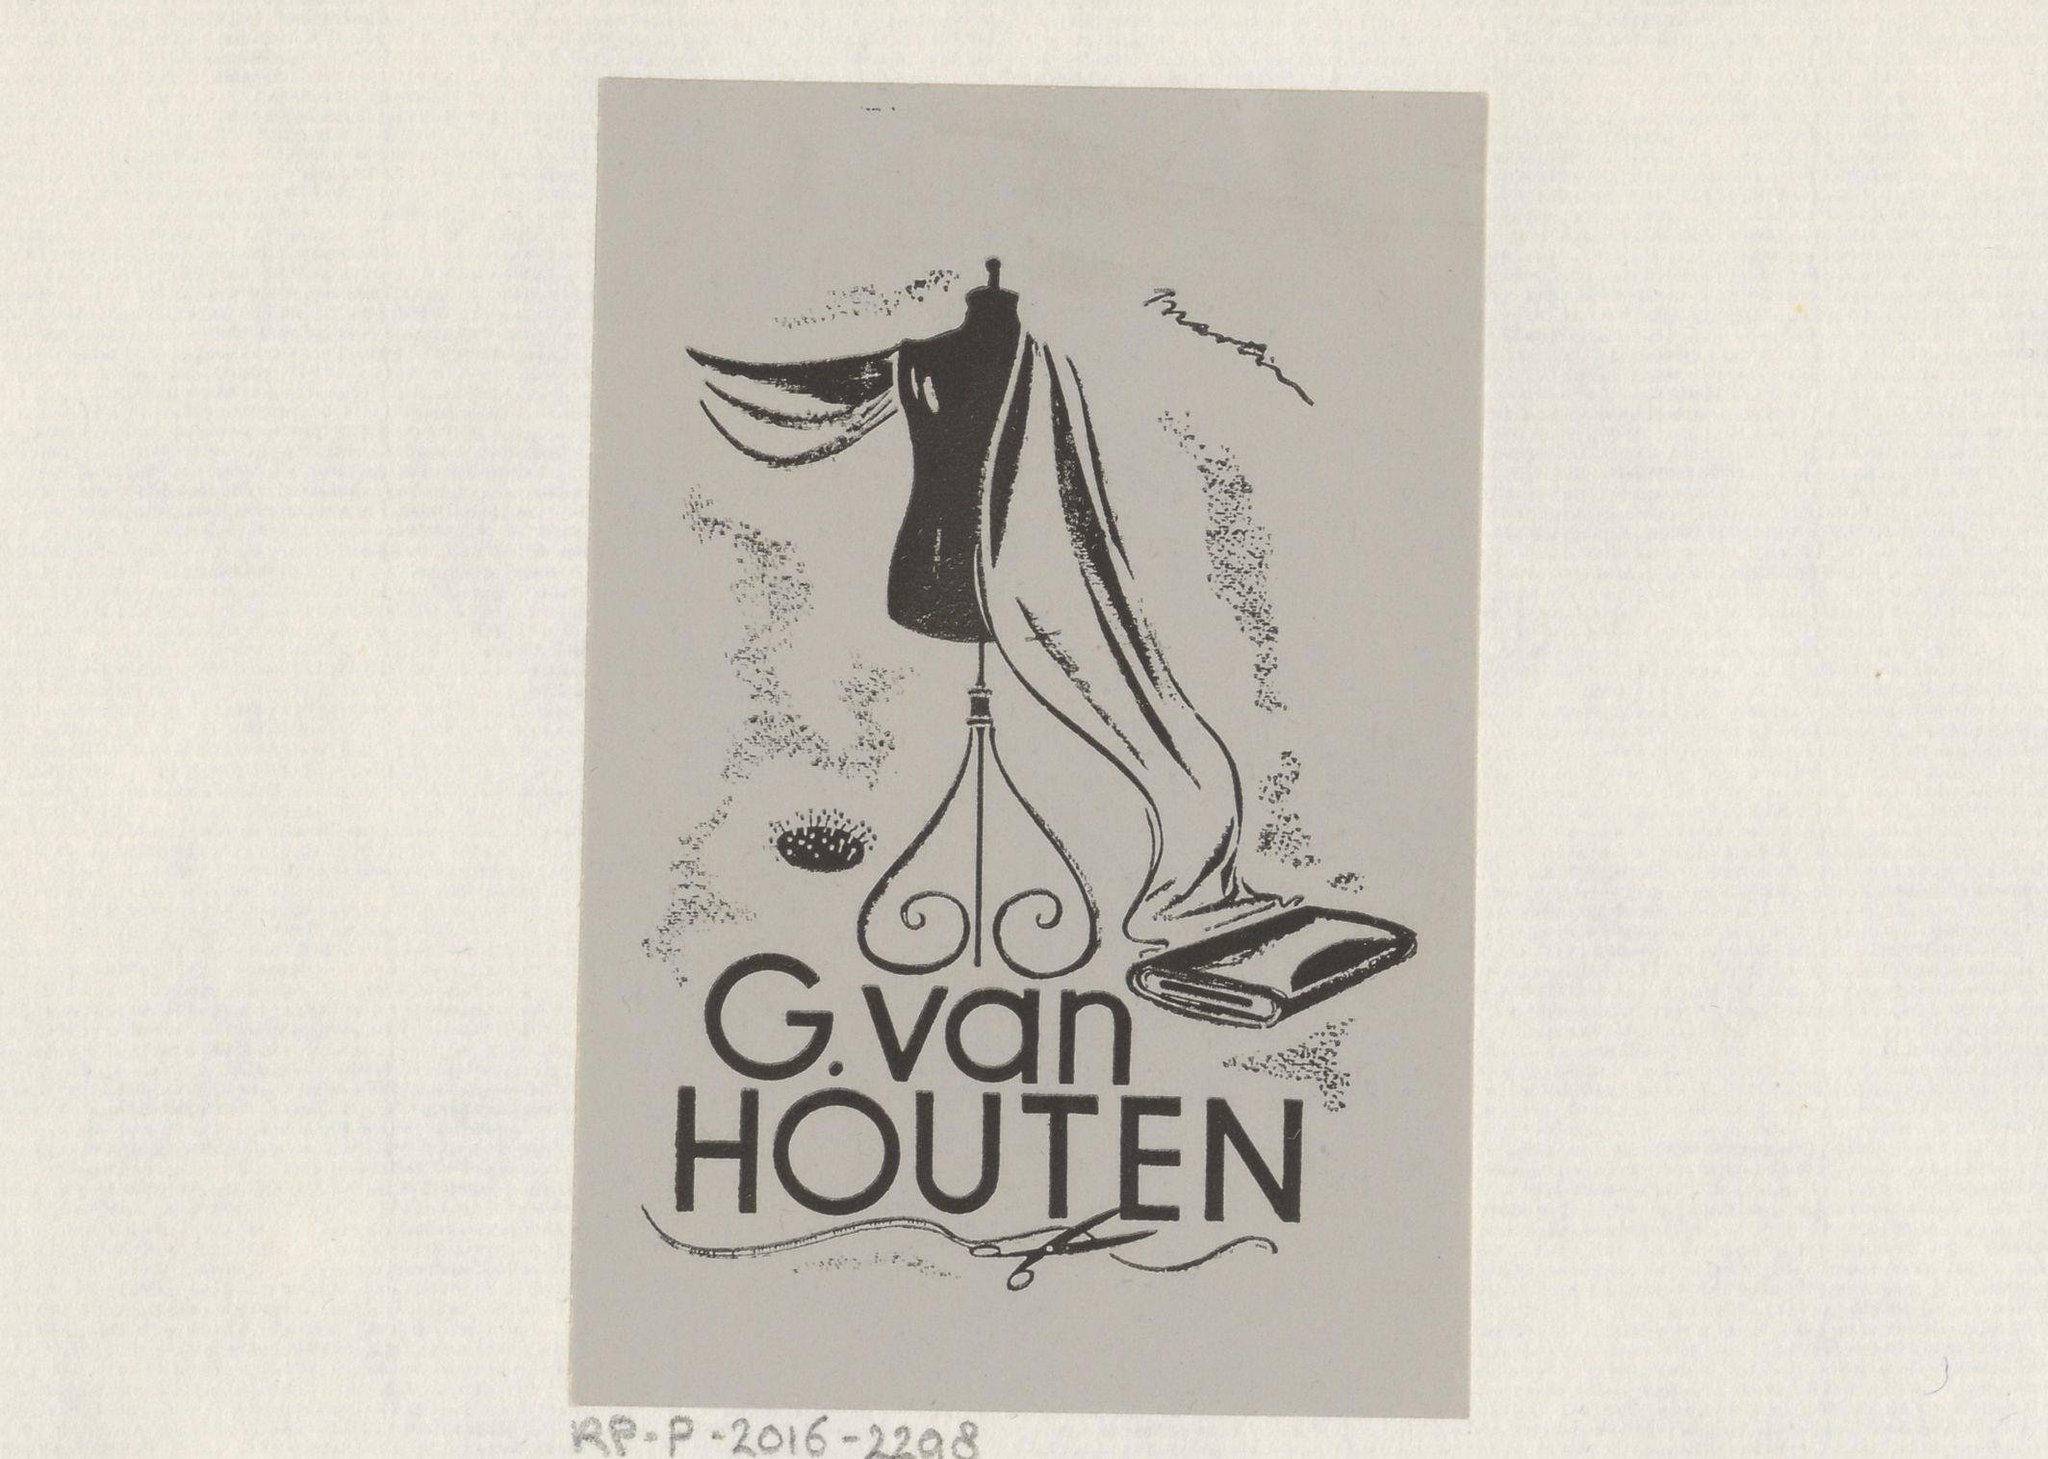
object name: bookplate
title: Ex libris van G. van Houten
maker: martin horwitz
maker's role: print maker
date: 1942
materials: paper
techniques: printing block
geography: netherlands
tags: model, mannequin, textile fabric, cloth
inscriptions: inscription: ‘Martin Horwitz '42’